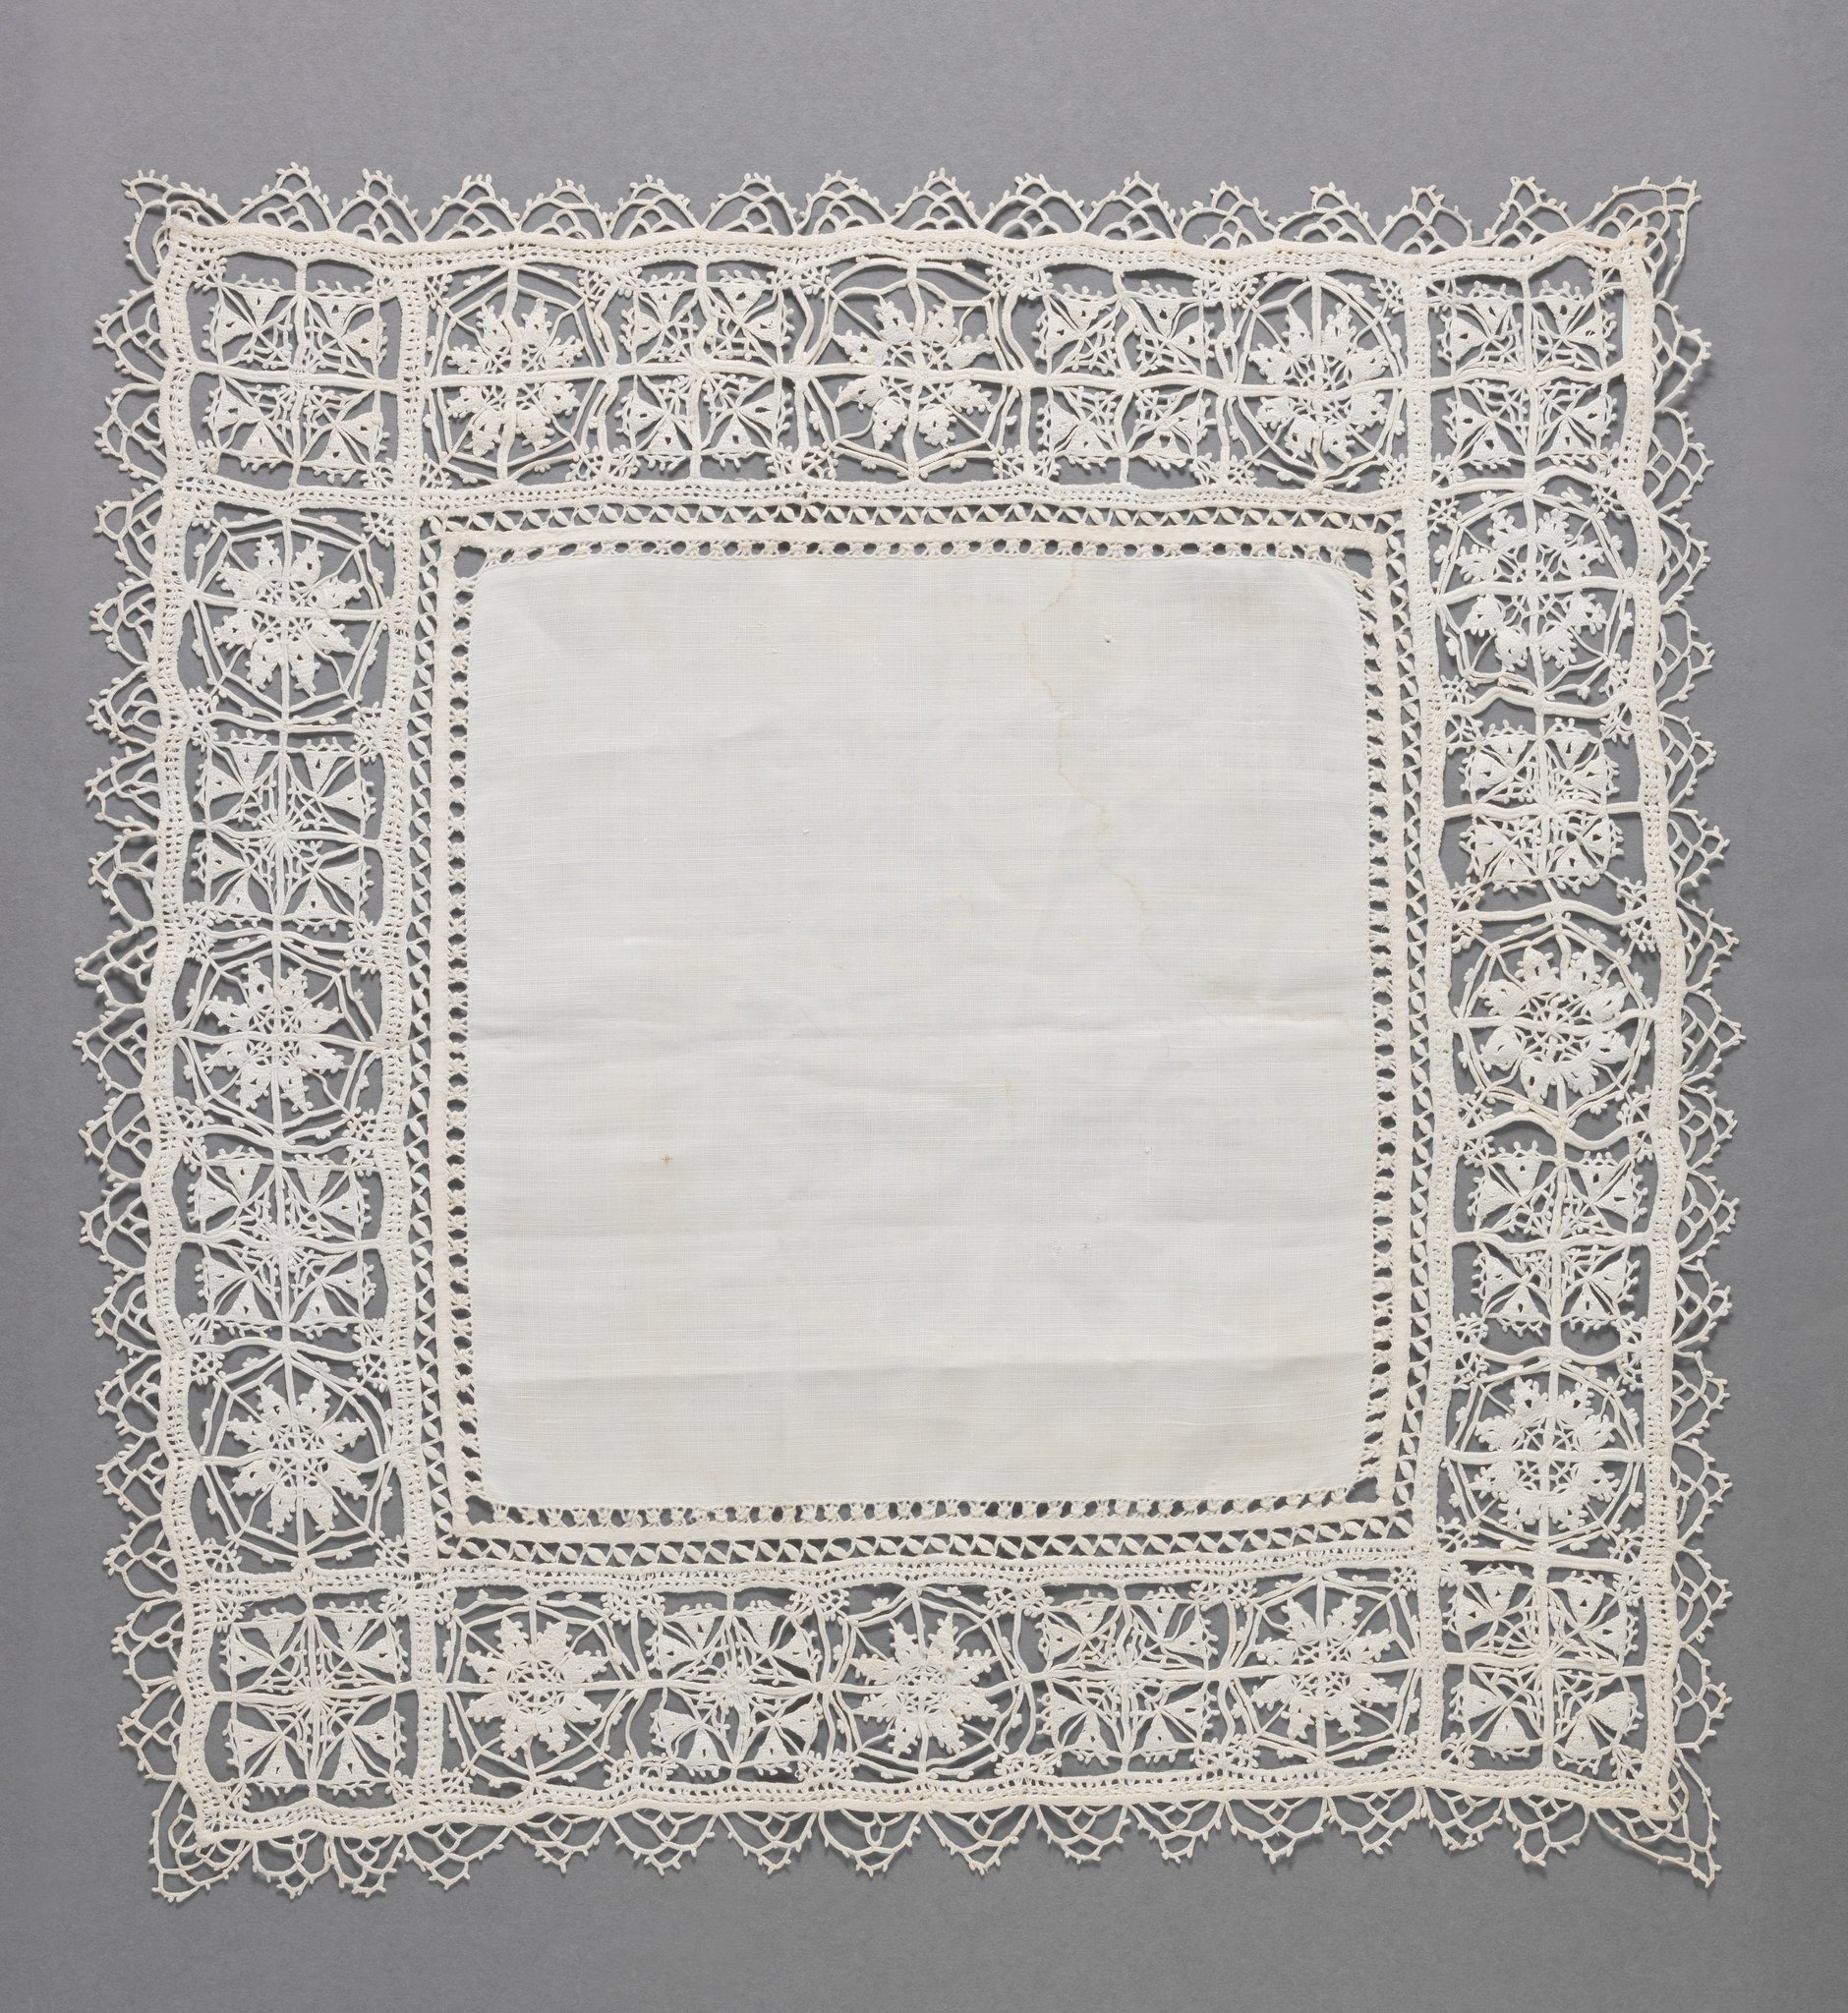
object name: cover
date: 1601-1700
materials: linen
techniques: lace